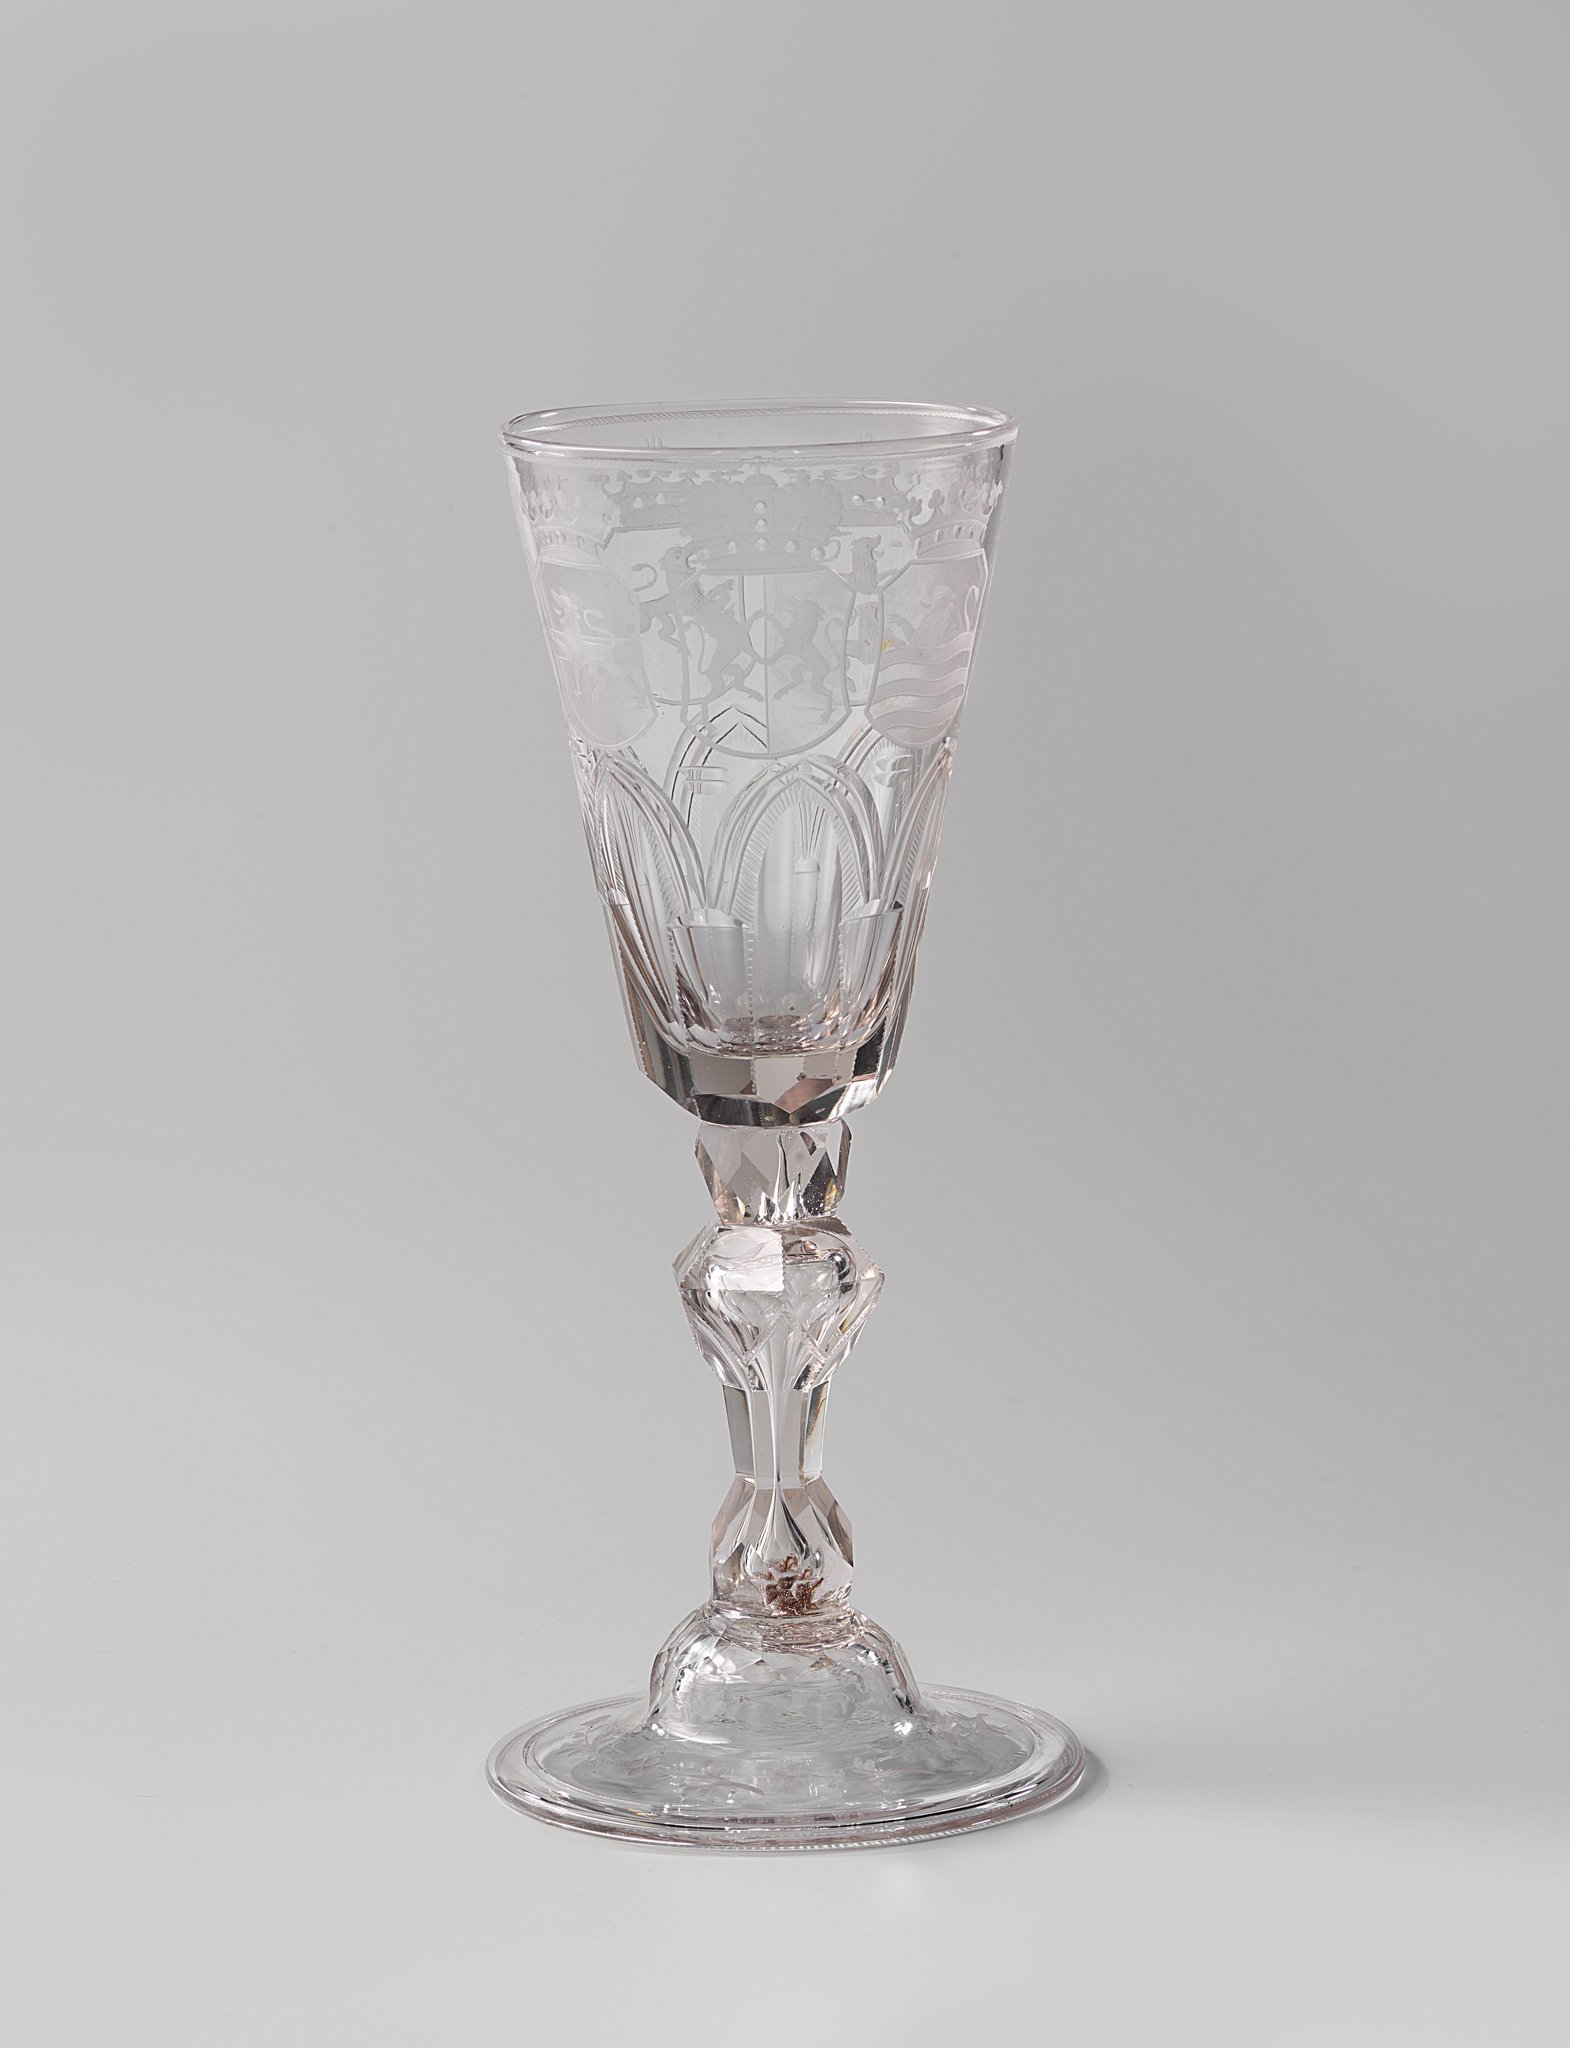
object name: goblet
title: Bokaal met de wapens van de Zeven Verenigde Provincieën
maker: Anonymous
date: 1725-1750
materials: glass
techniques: glassblowing, grinding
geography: germany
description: Bokaal met gewelfde, gefacetteerde voet met omgeslagen rand. Gefacetteerde balusterstam met drie knopen en een langgerekte luchtbel. Op de conische kelk de gekroonde wapens van de Zeven Verenigde Gewesten.